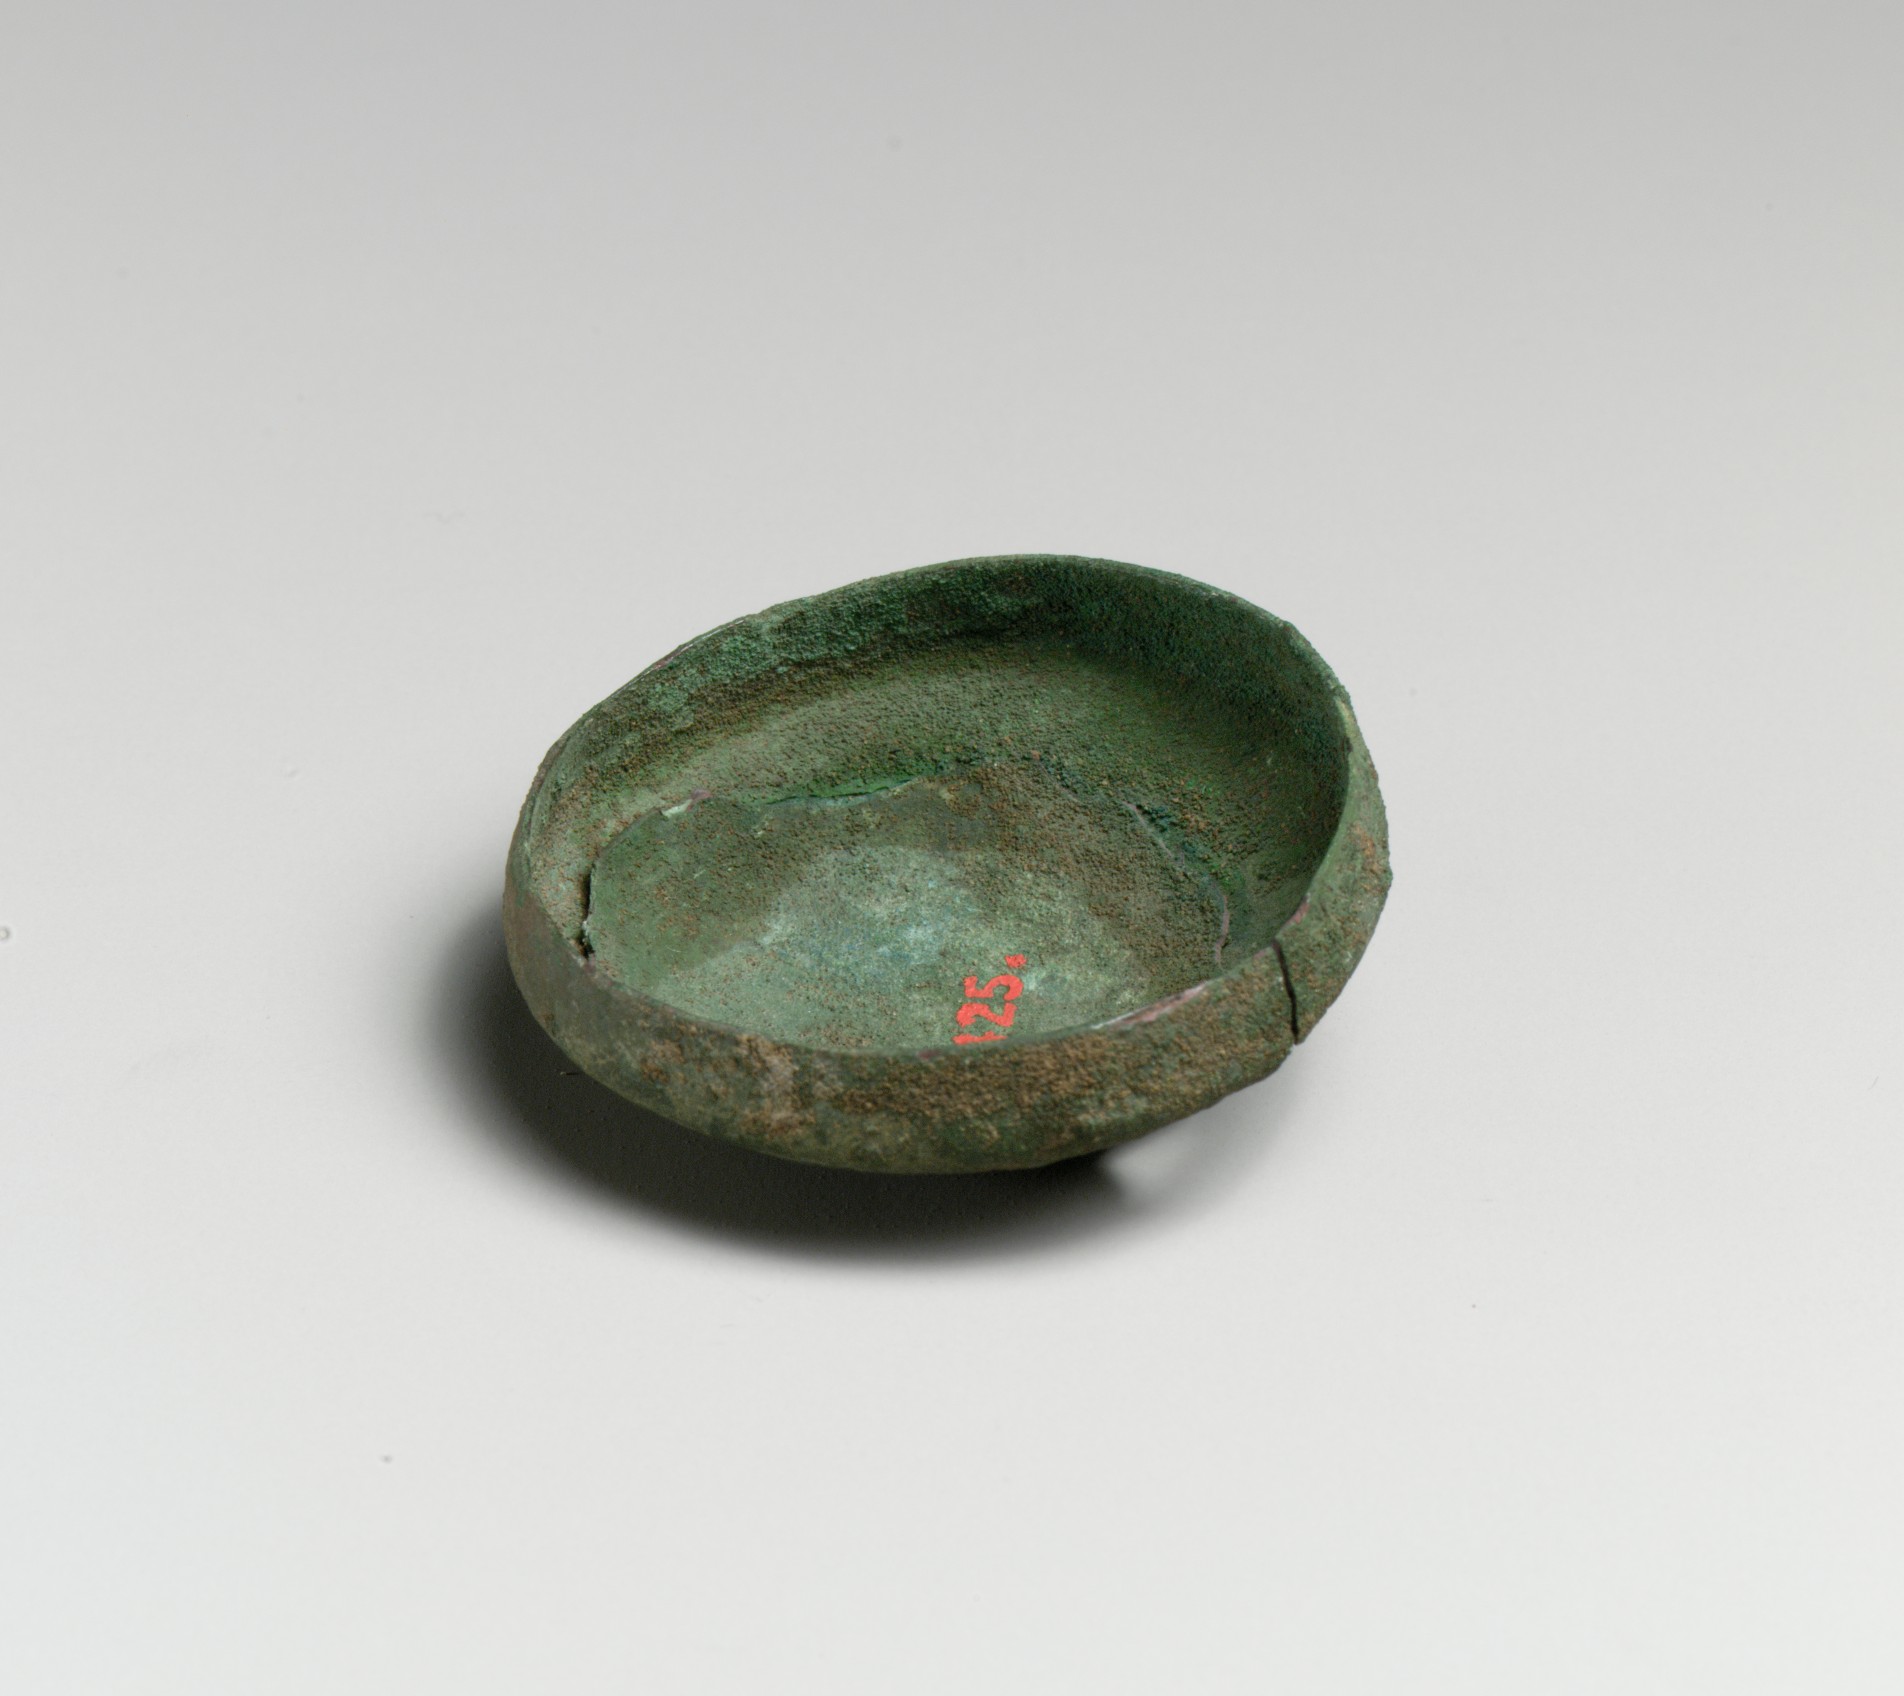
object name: lid or bos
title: Lid or boss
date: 7000 BCE-330 CE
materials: bronze